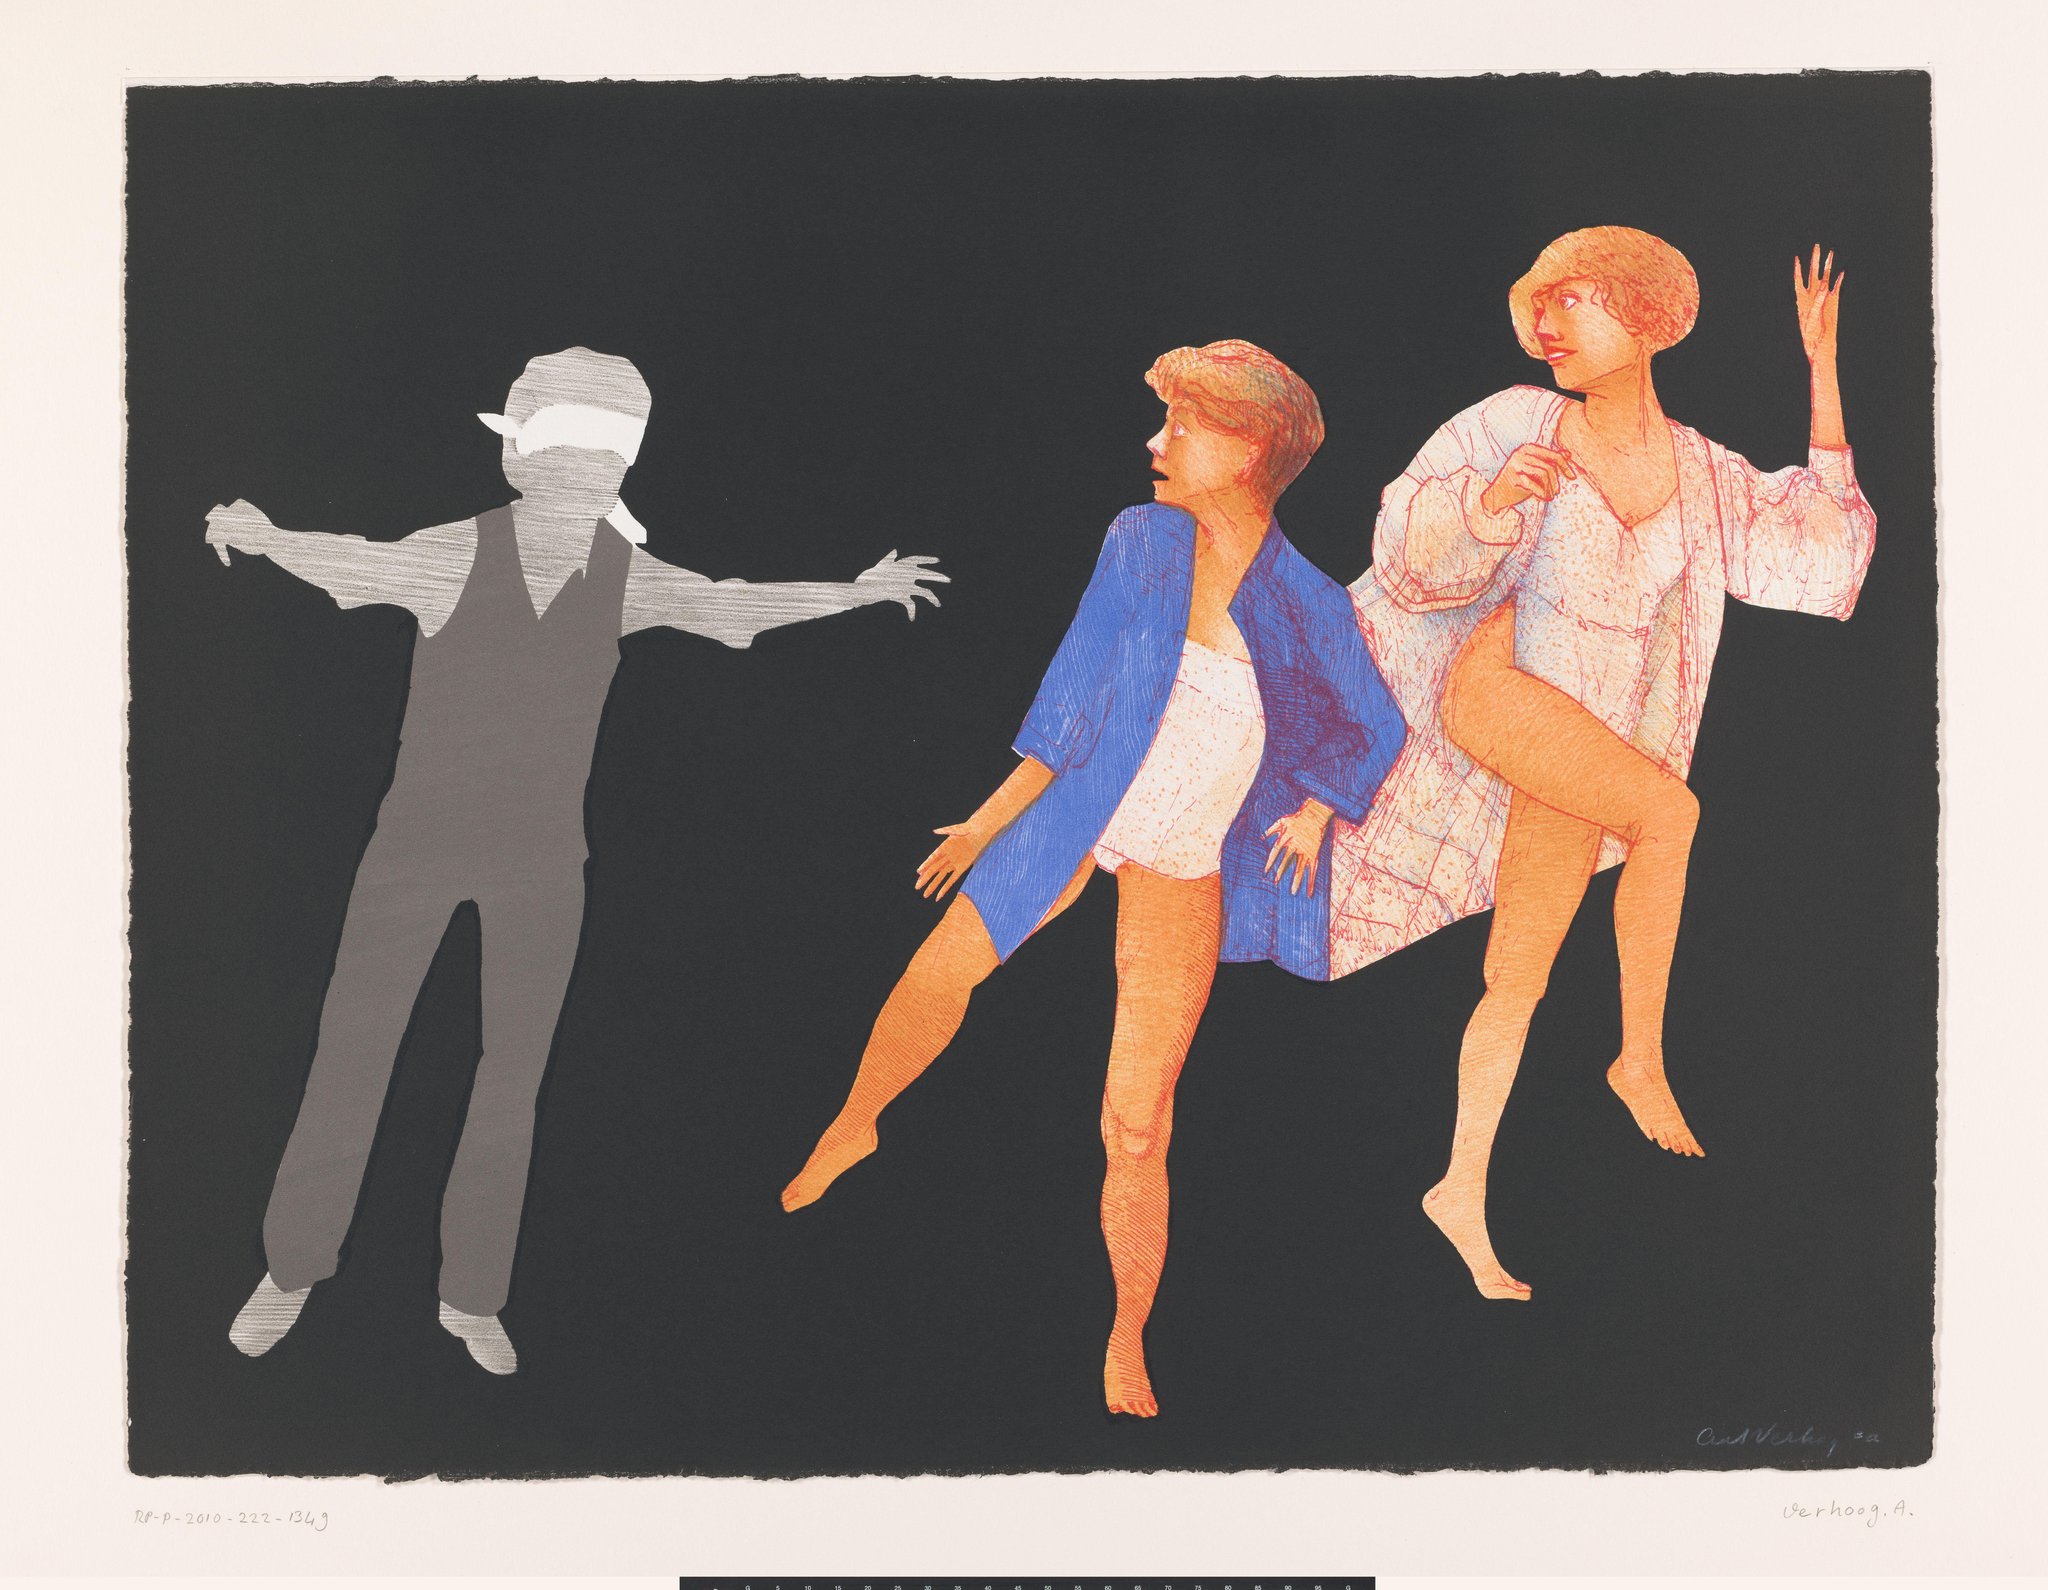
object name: print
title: Geblinddoekte man en twee vrouwen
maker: aat verhoog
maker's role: print maker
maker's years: 1933-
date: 1965-1980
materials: paper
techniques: screen printing in color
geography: netherlands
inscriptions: signature: ‘Aat Verhoog’, edition: ‘e.a.’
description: Geblinddoekte man op de tast zoekend naar twee vrouwen in nachtkleding, tegen een gitzwarte achtergrond.